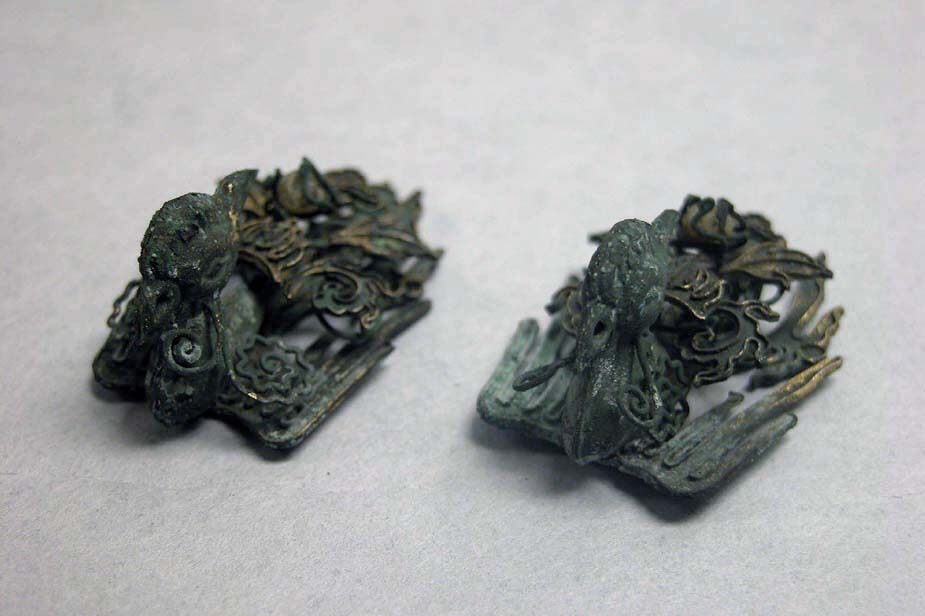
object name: hair ornament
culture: chinese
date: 960-1279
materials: silver gilt